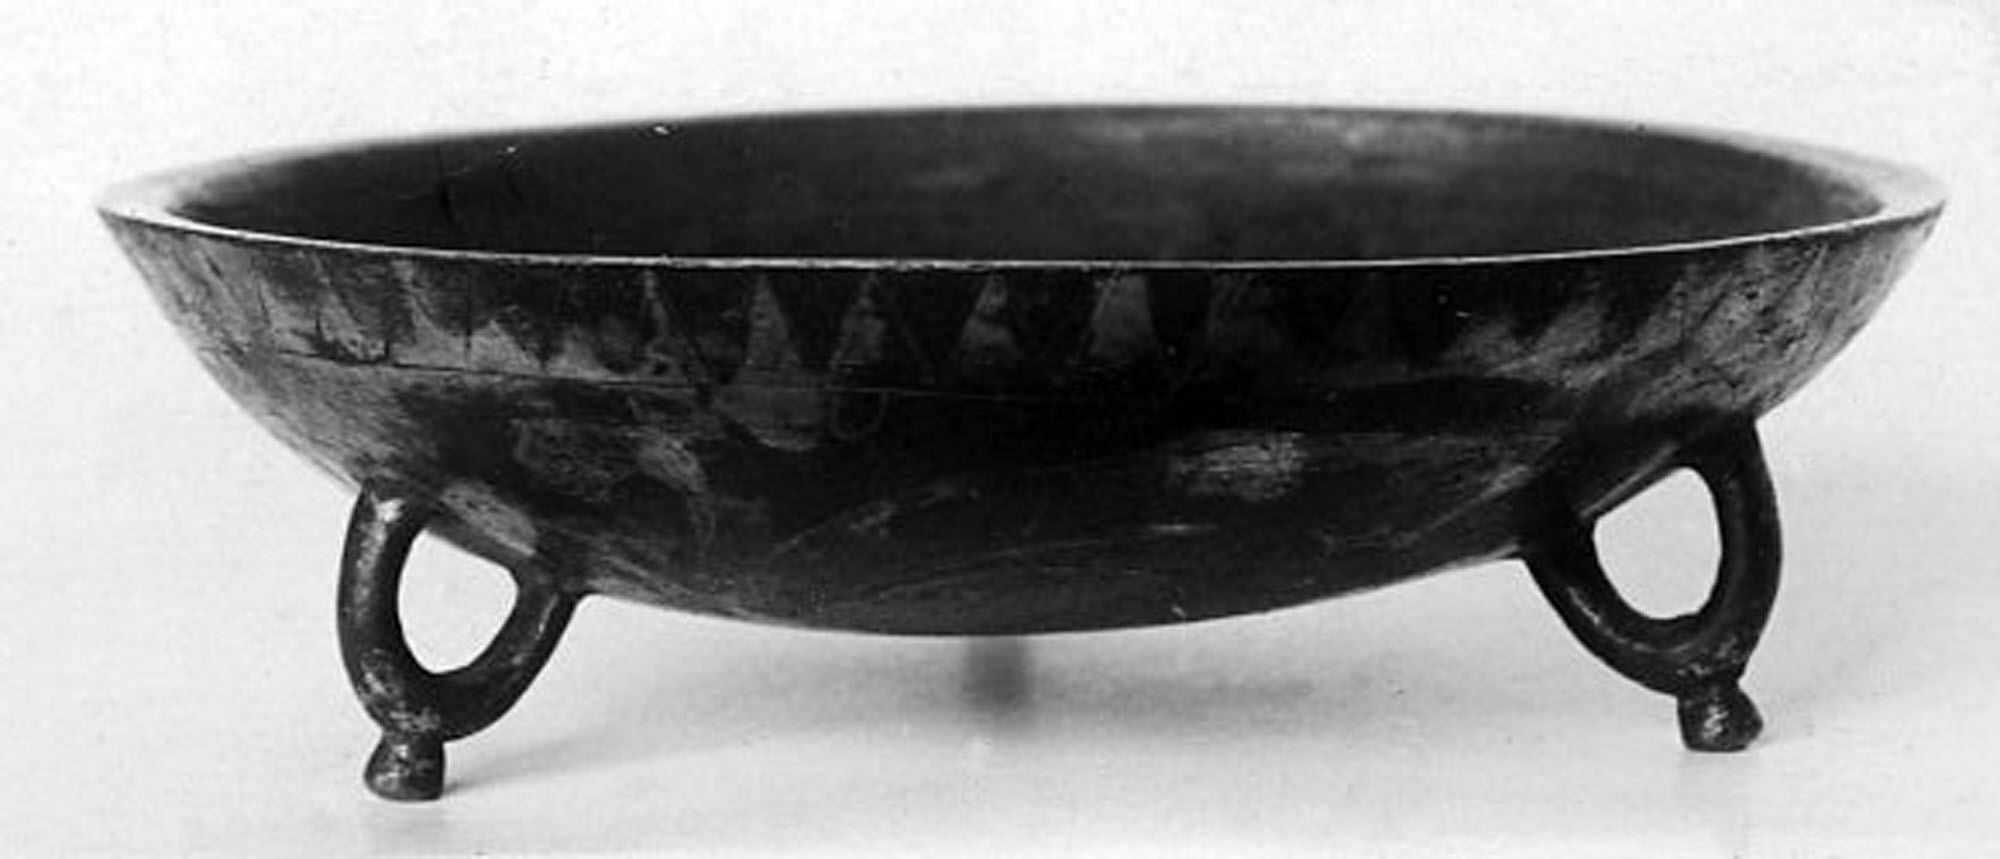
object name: saucer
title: Cover with three ring handles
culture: chinese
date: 300-101 BCE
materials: gilt bronze